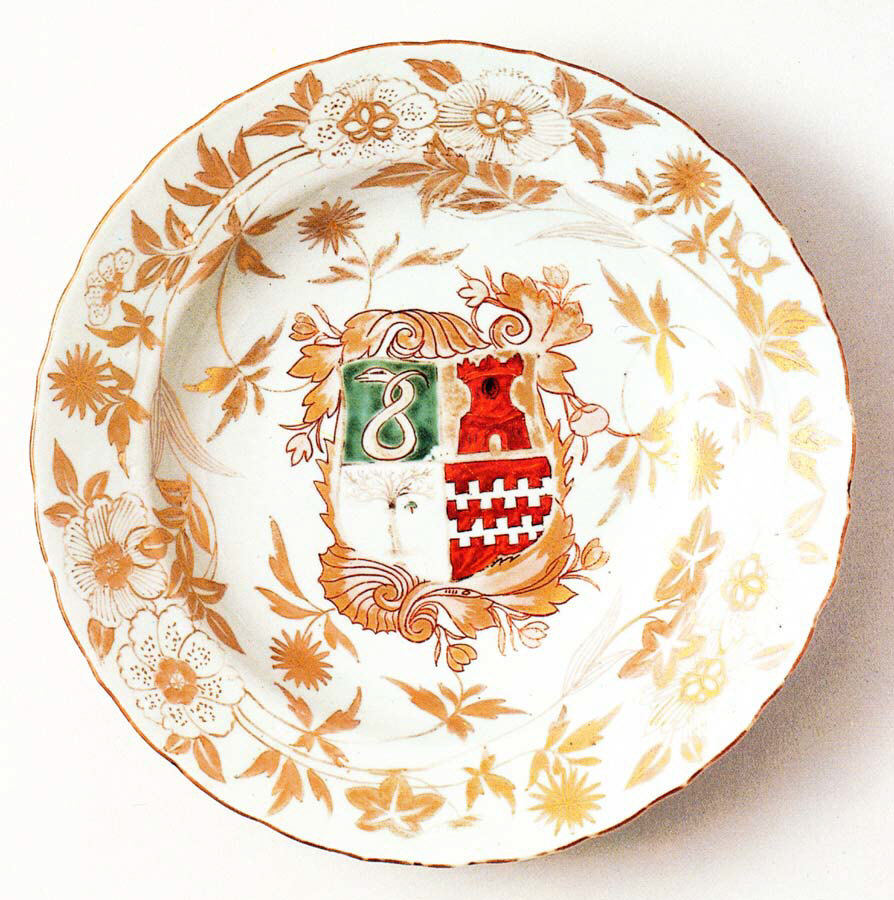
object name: plate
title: Armorial Plate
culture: japanese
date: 1701-1800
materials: enamel, gold, porcelain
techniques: overglaze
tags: flowers,leaves,emblems